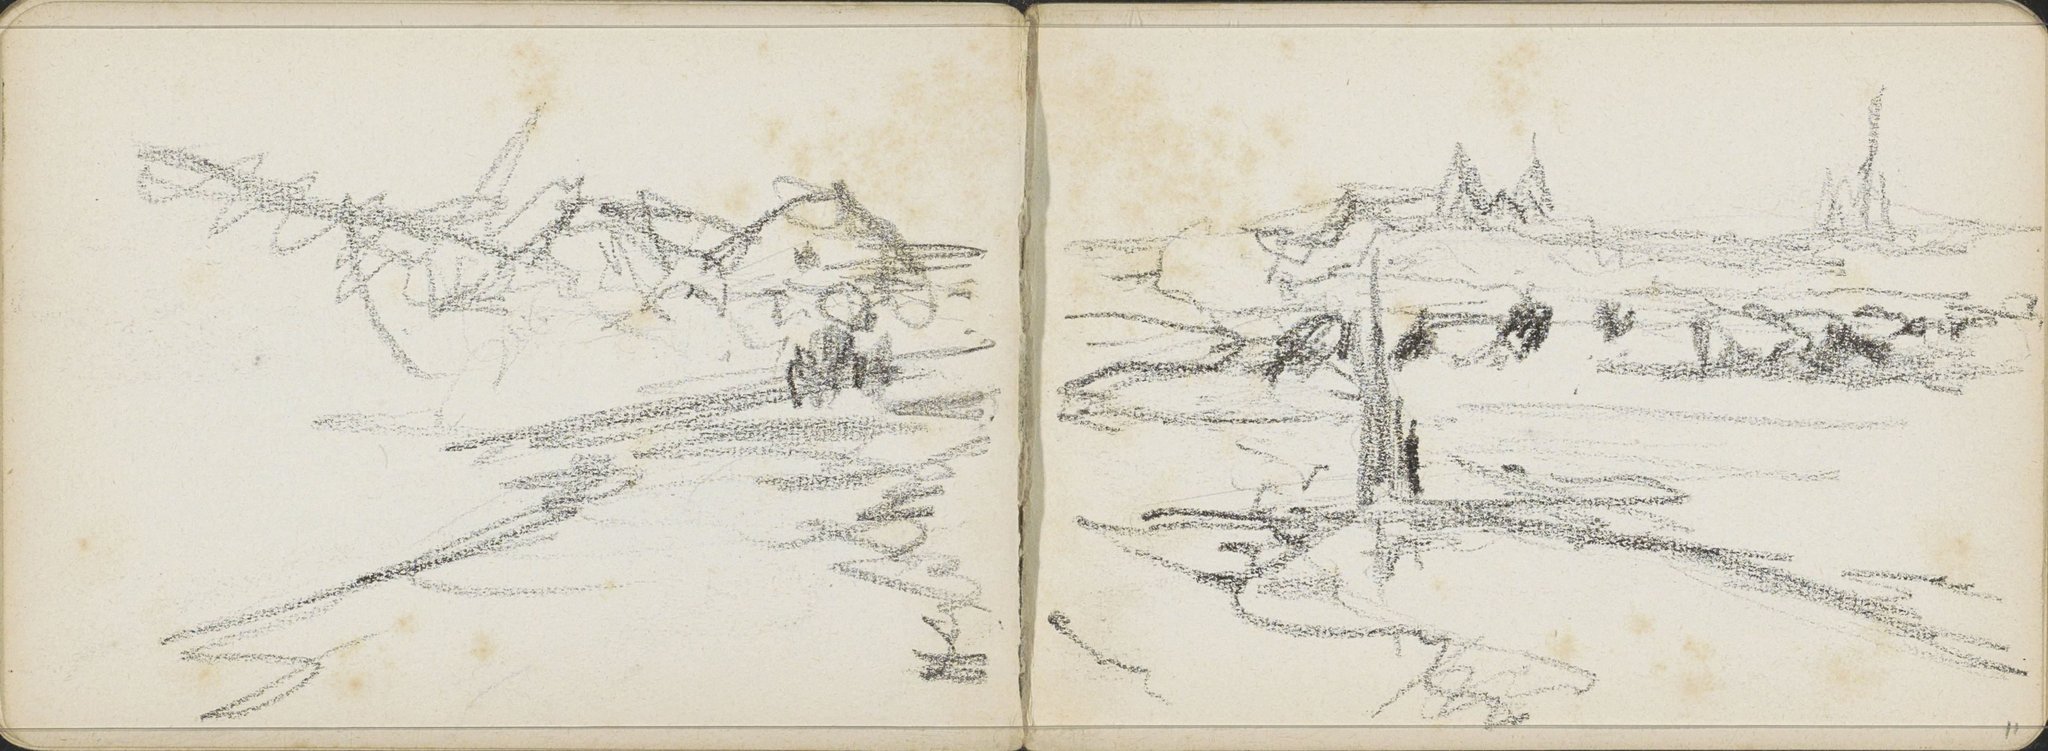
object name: sketchbook leaf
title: Landschap met bebouwing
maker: willem cornelis rip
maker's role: draughtsman, painter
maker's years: 1856-1922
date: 1866-1922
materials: chalk, paper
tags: city-view, and landscape with man-made constructions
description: Blad 10 verso en 11 recto uit een schetsboek met 42 bladen.